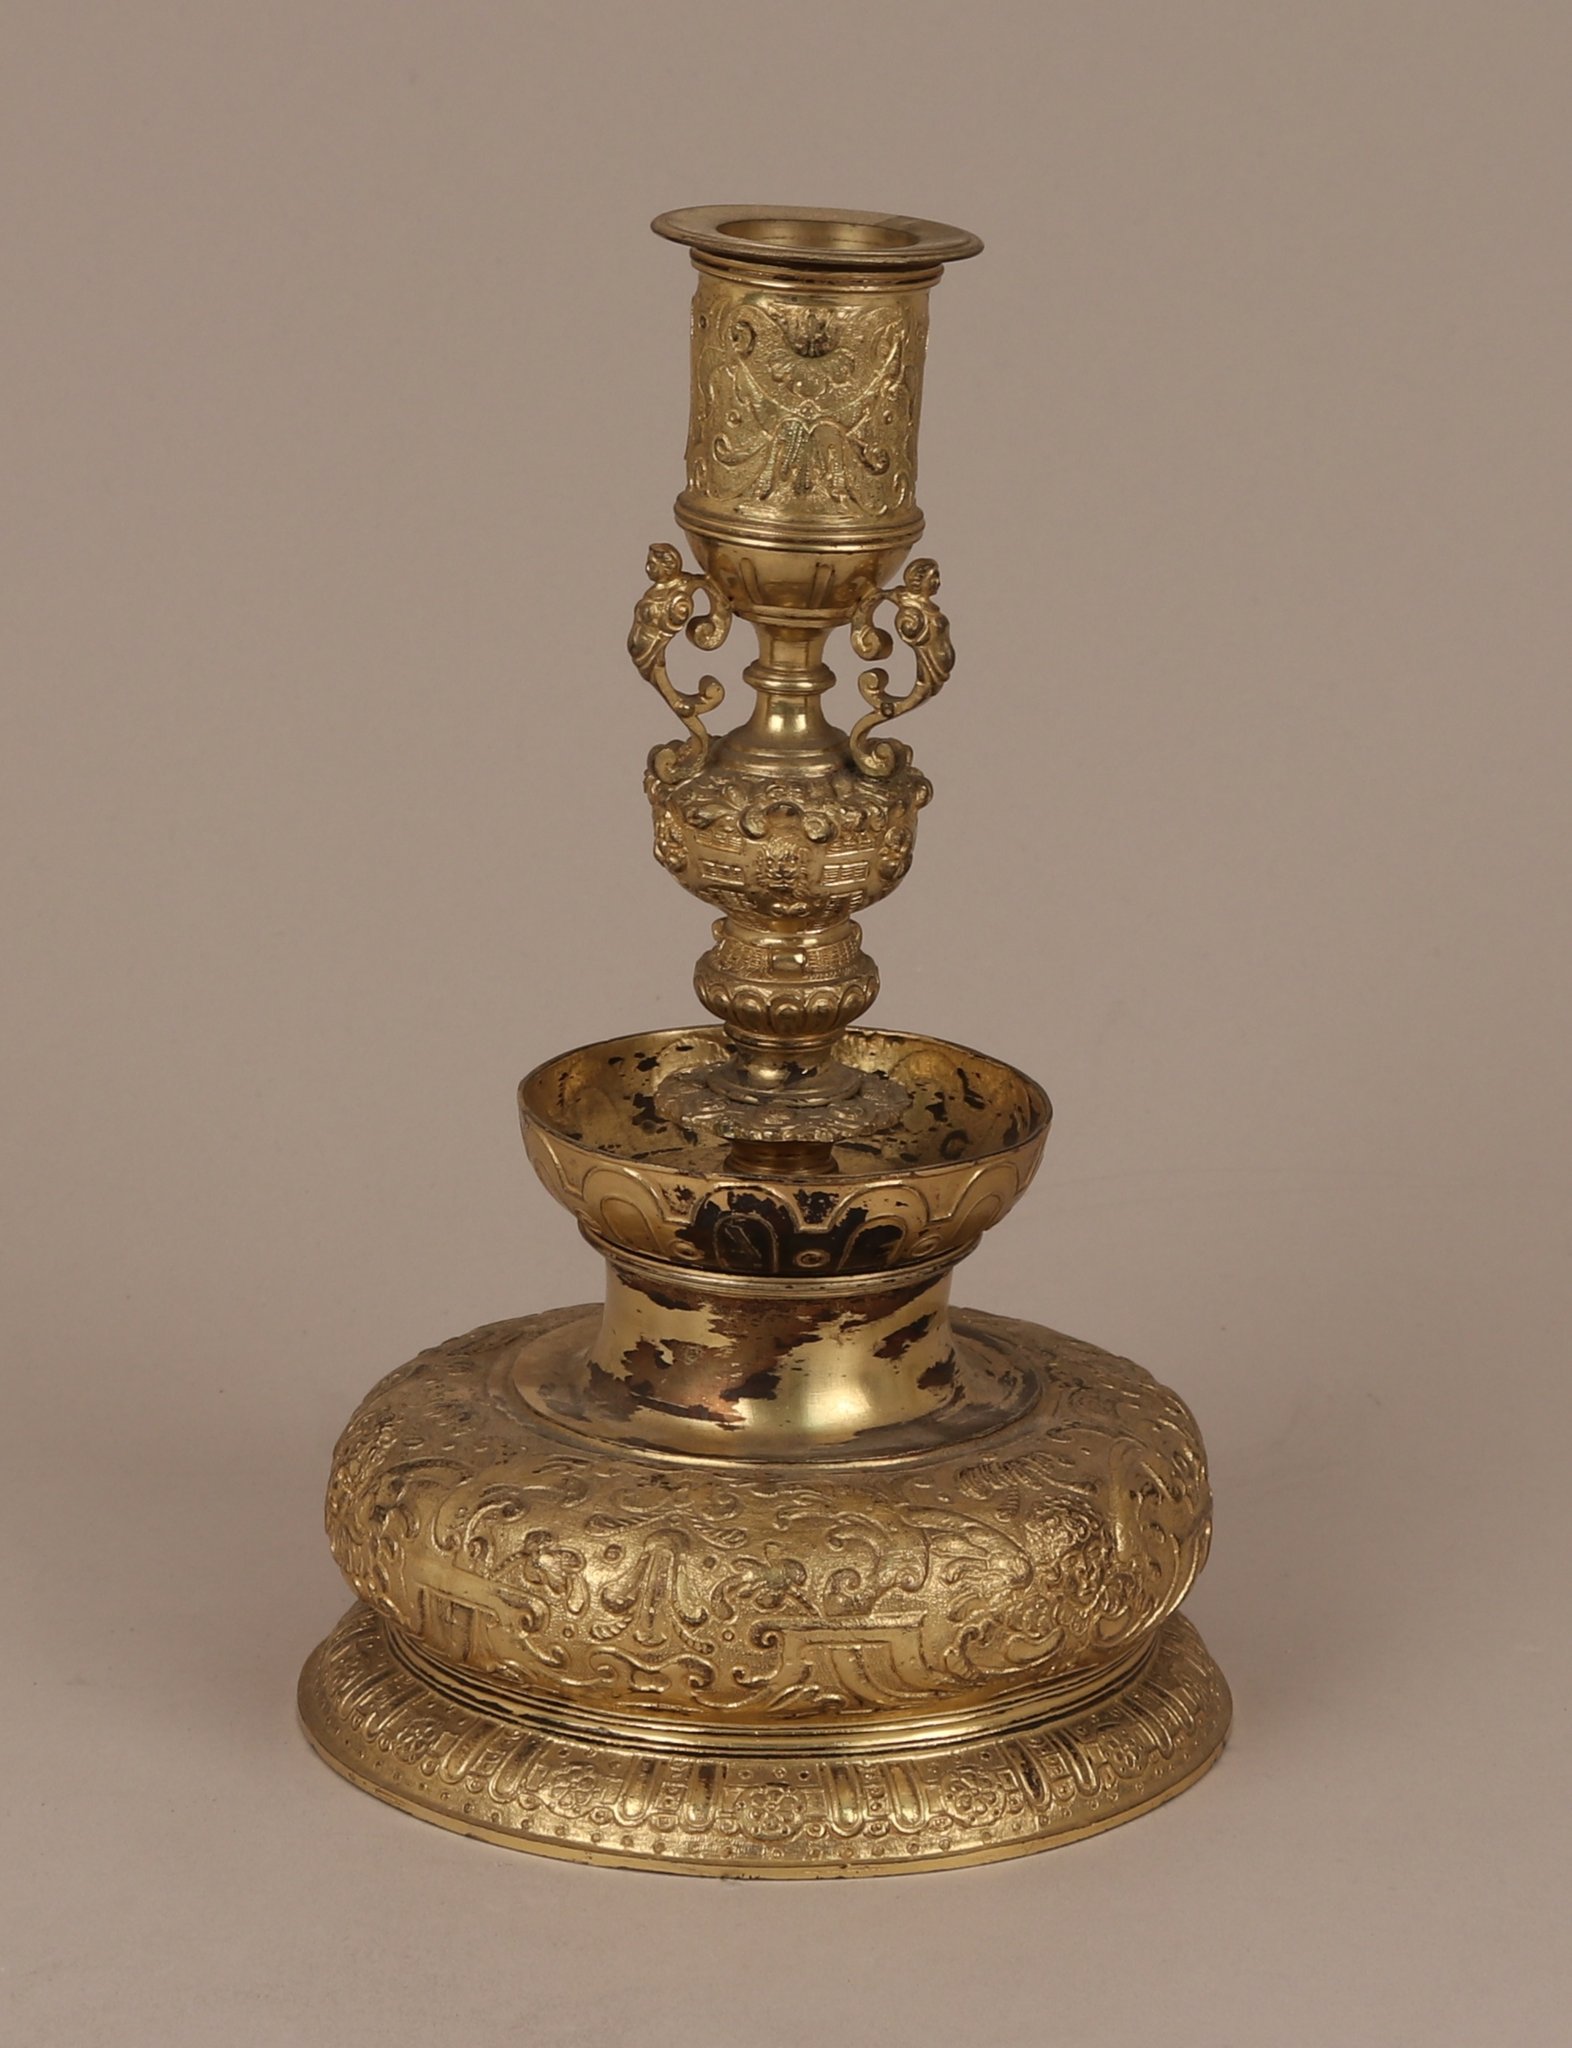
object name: candlestick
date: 1801-1900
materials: metal, silver